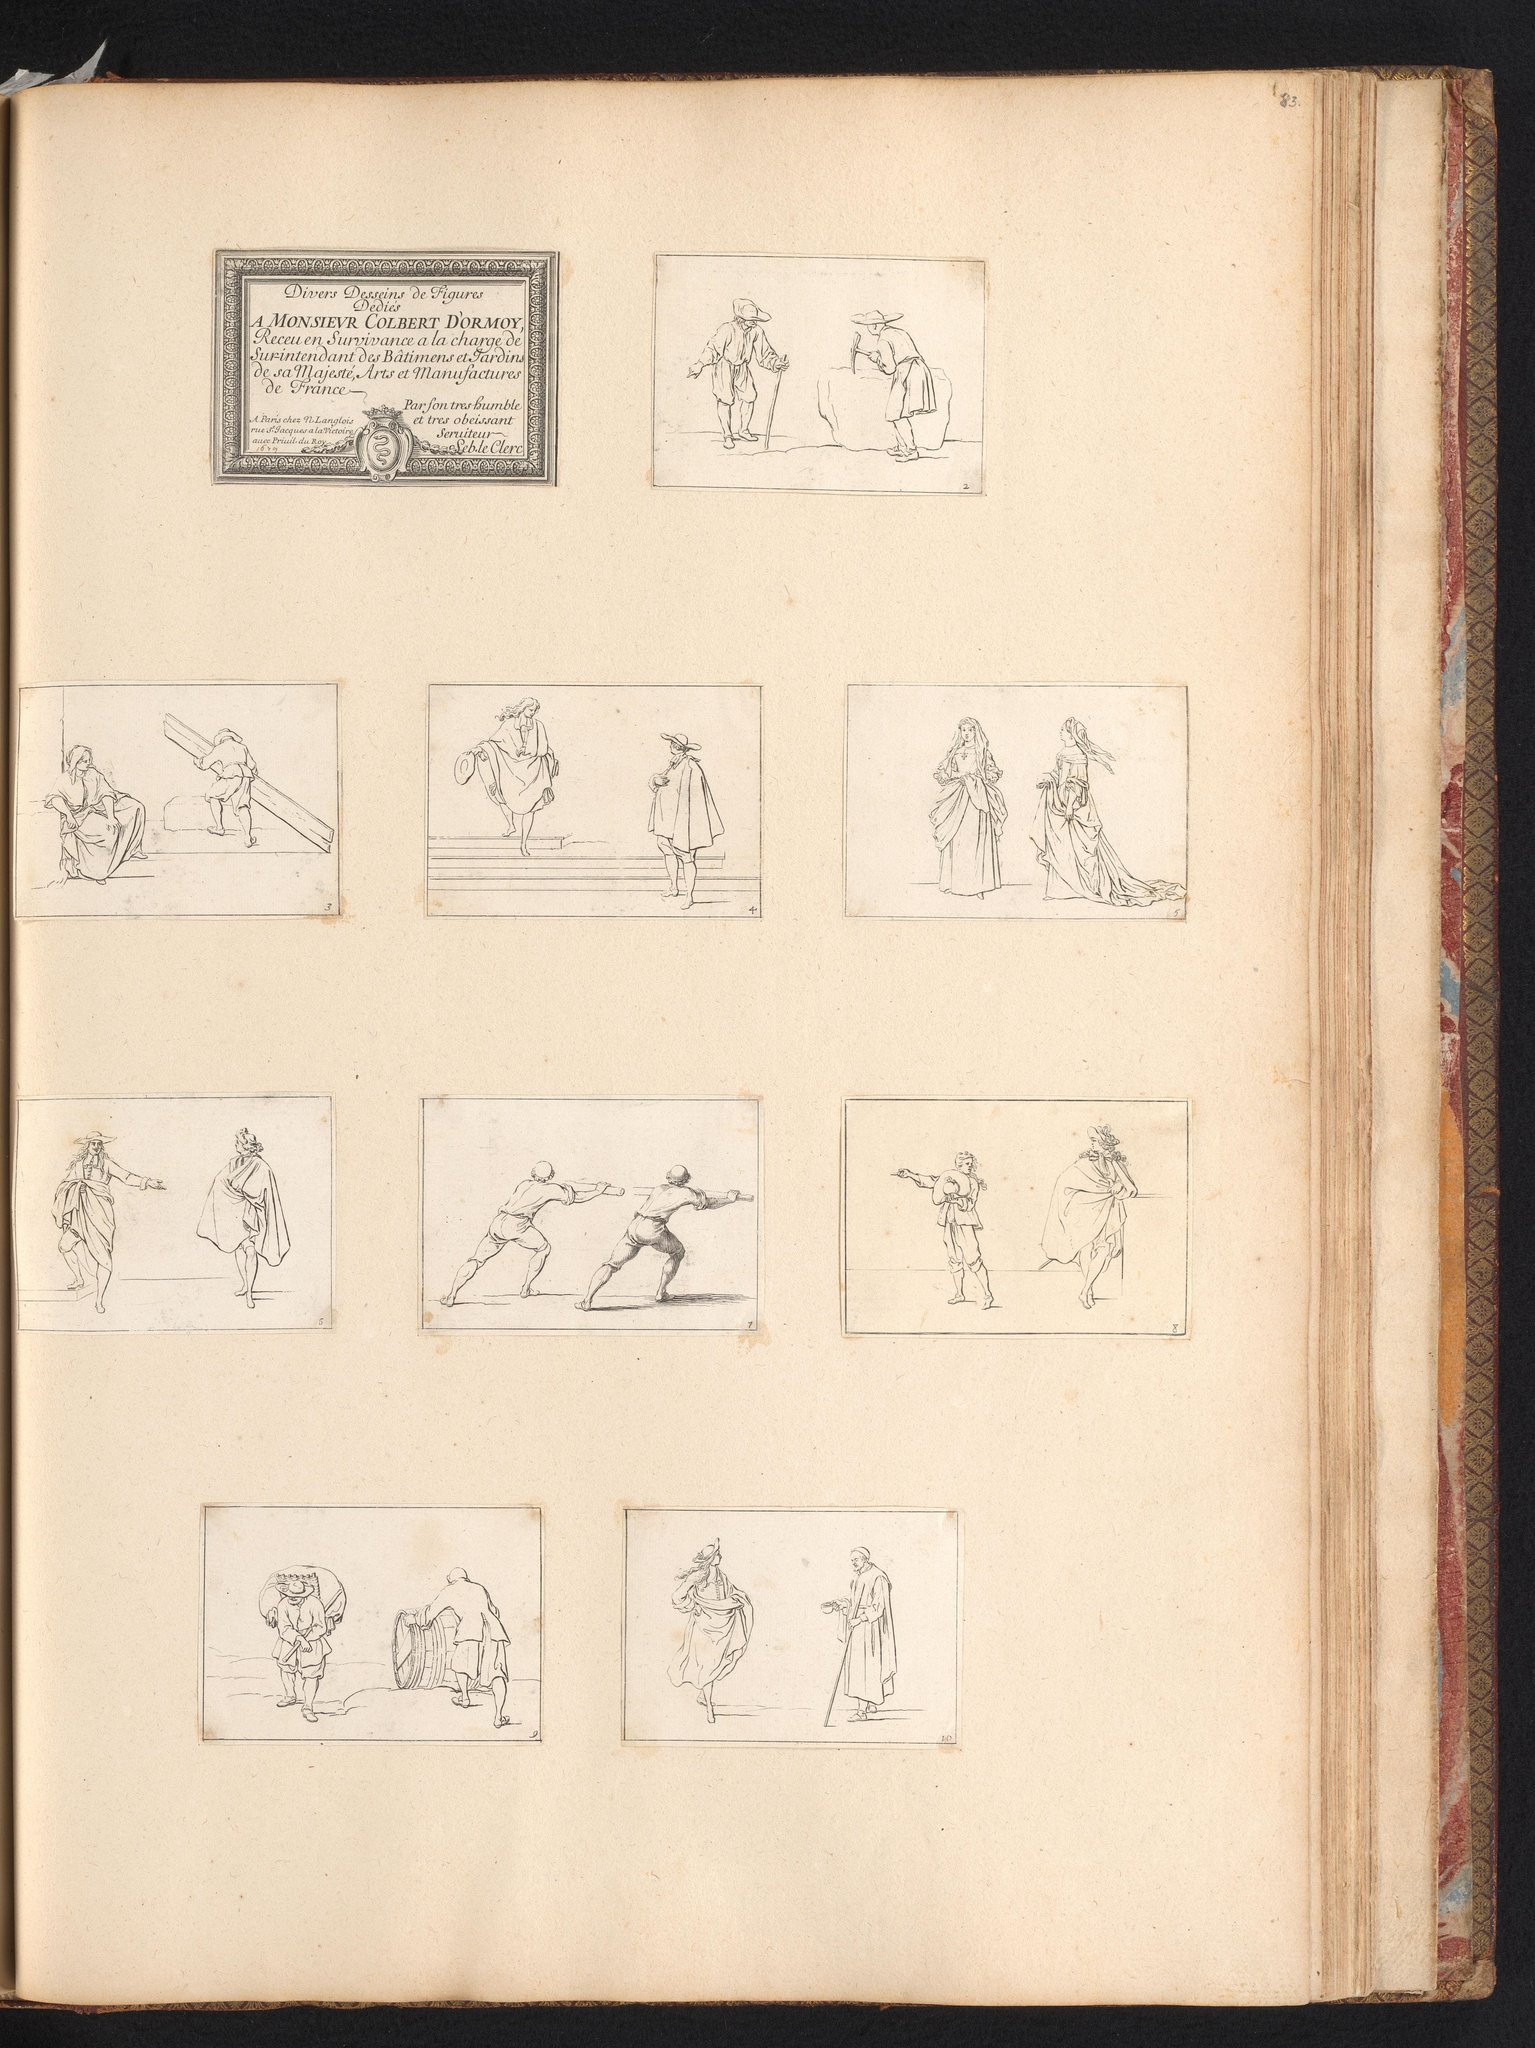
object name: album leaf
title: Divers Desseins de Figures Dedies a Monsieur Colbert d'Ormoy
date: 1679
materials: paper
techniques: etching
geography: paris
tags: model-books ~ implements of painter, folk costume, regional costume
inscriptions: inscription: ‘1679’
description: Deze prenten en titelprent maken deel uit van een dertigdelige serie met tekenvoorbeelden van verschillende alledaagse figuren. Zoals vermeld in IFF 17e siècle leerde Leclerc Colbert volgens Jombert vanaf 1679 tekenen. Hij vervaardigde deze reeks voor Colbert om het leerproces te faciliteren. Op ieder tekenvoorbeeld staan twee figuren, waarvan soms hetzelfde figuur twee keer, soms in een andere pose, soms voorzien van arceringen.